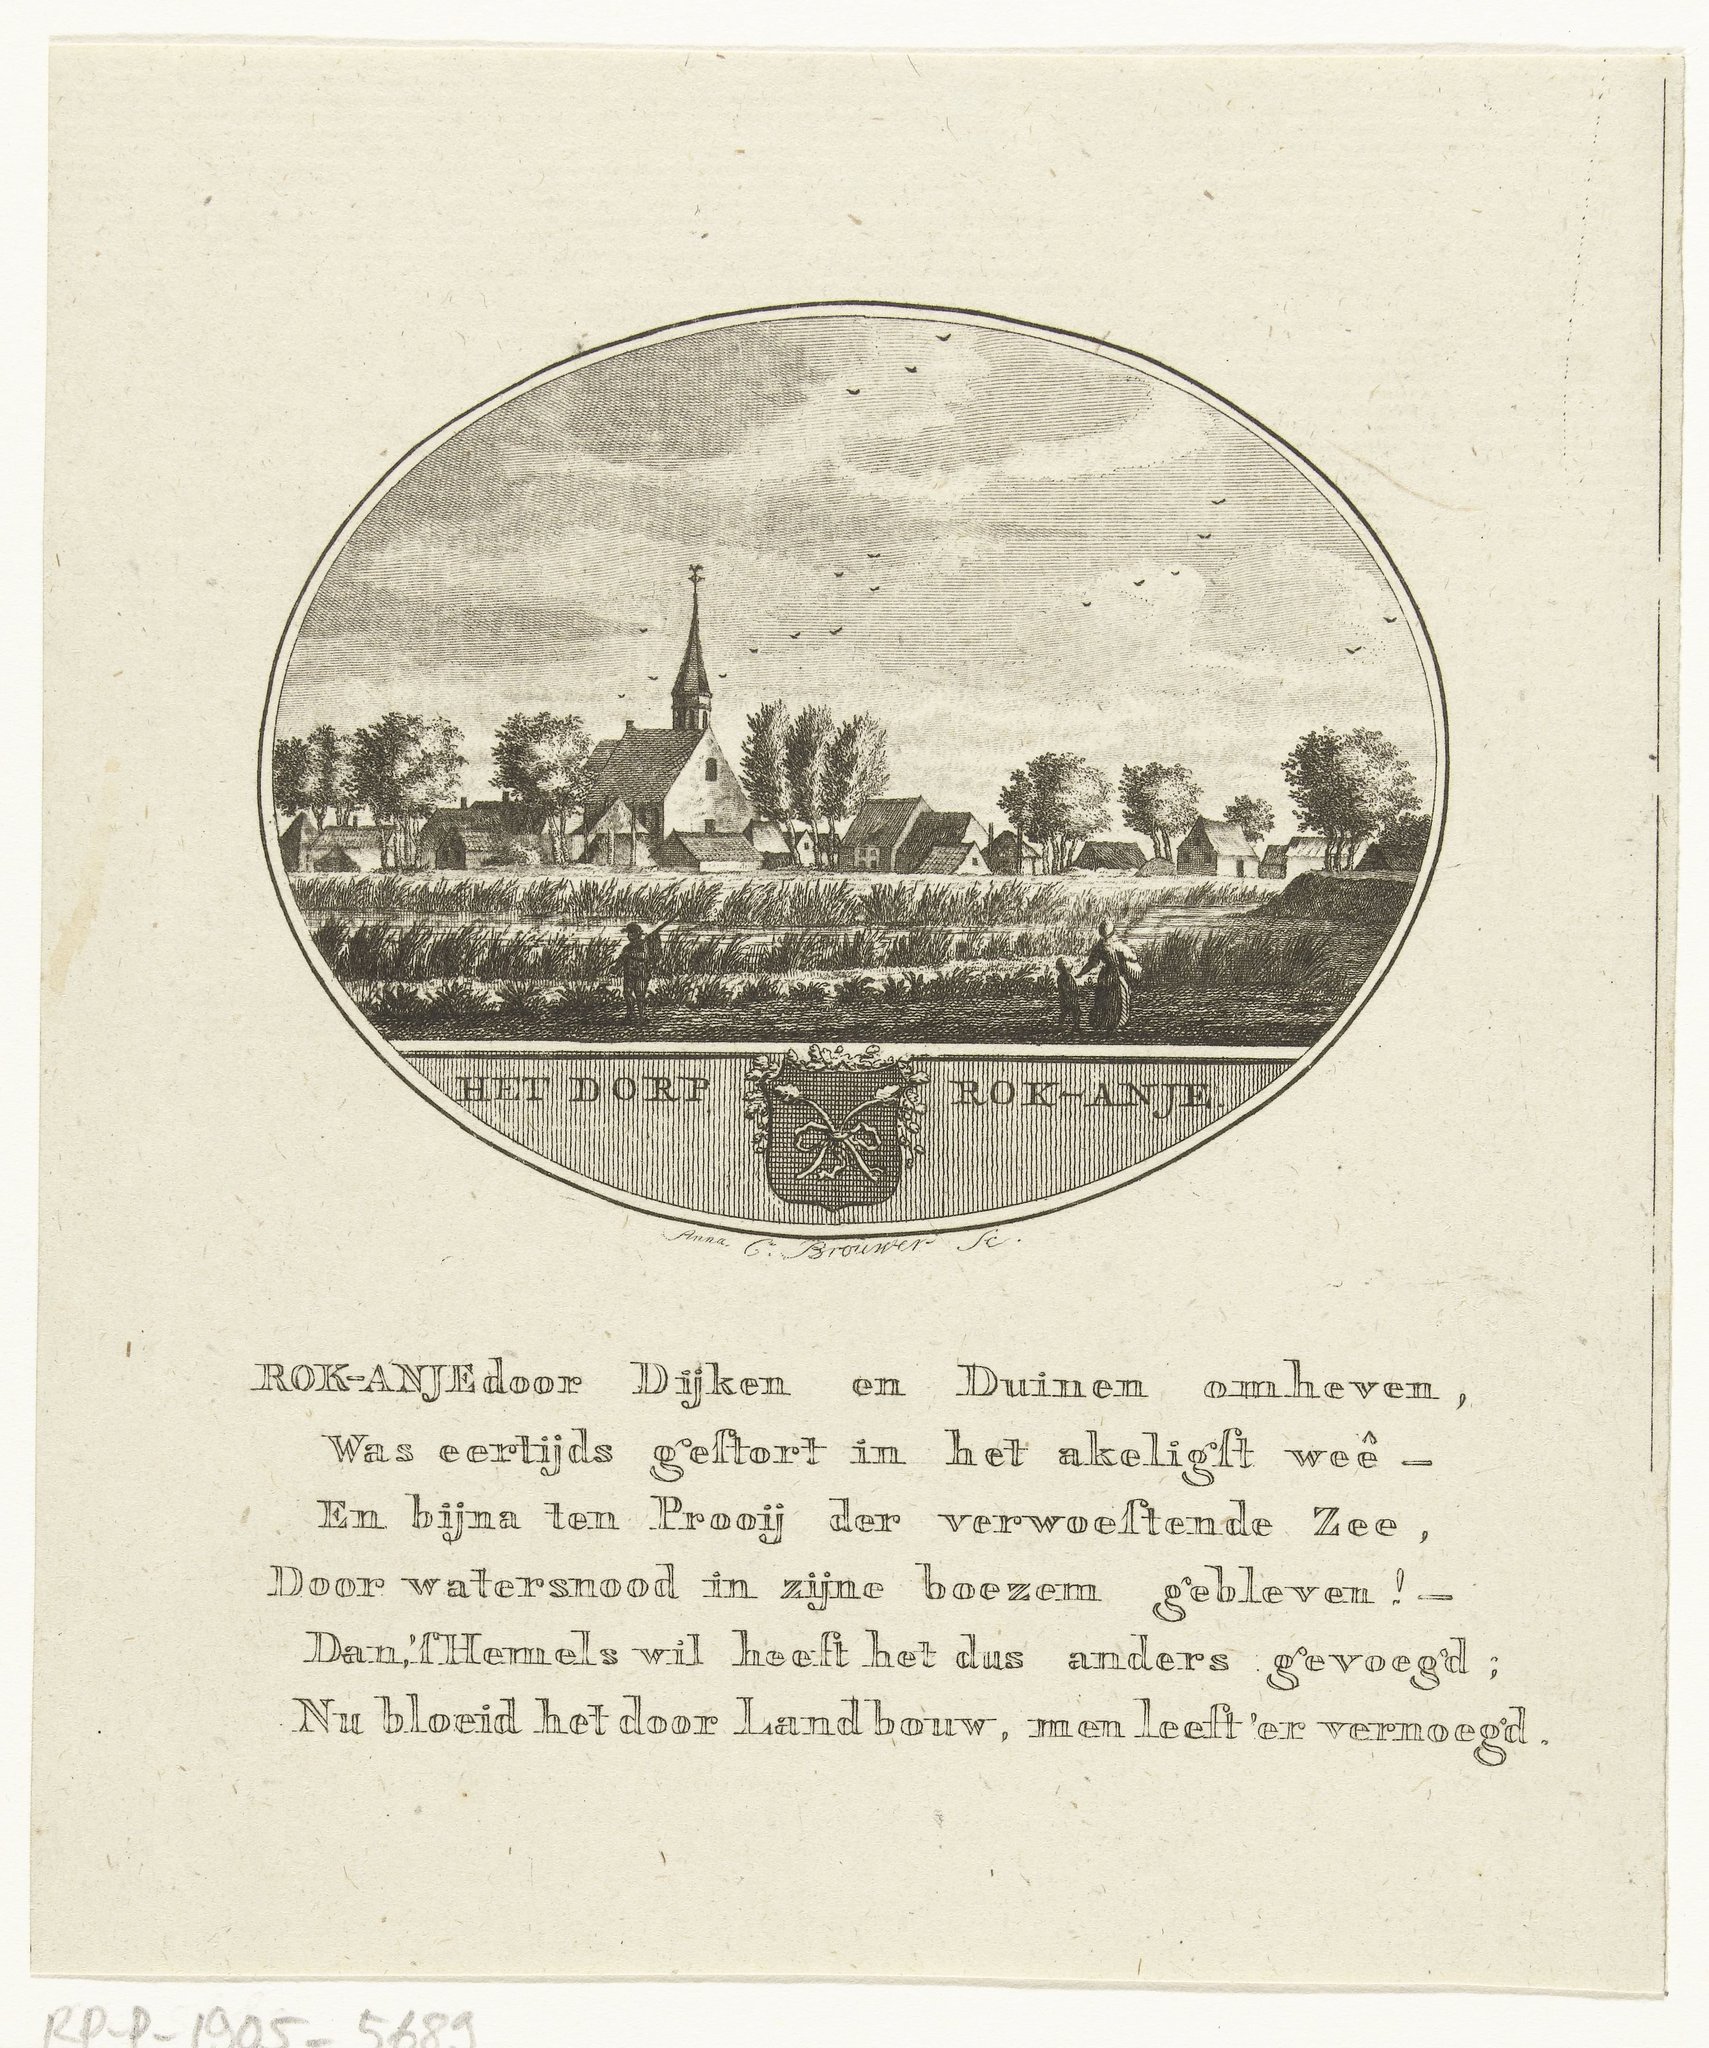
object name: book illustration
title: Gezicht op het dorp Rockanje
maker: anna catharina brouwer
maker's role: print maker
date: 1796-1798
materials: paper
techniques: etching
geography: amsterdam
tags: city-view in general; 'veduta'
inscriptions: collector's mark: Lugt 2228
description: afkomstig uit: L. van Ollefen, De Nederlandsche stad- en dorpbeschrijver. Deel 6. Amsterdam: H.A. Banse, 1798.